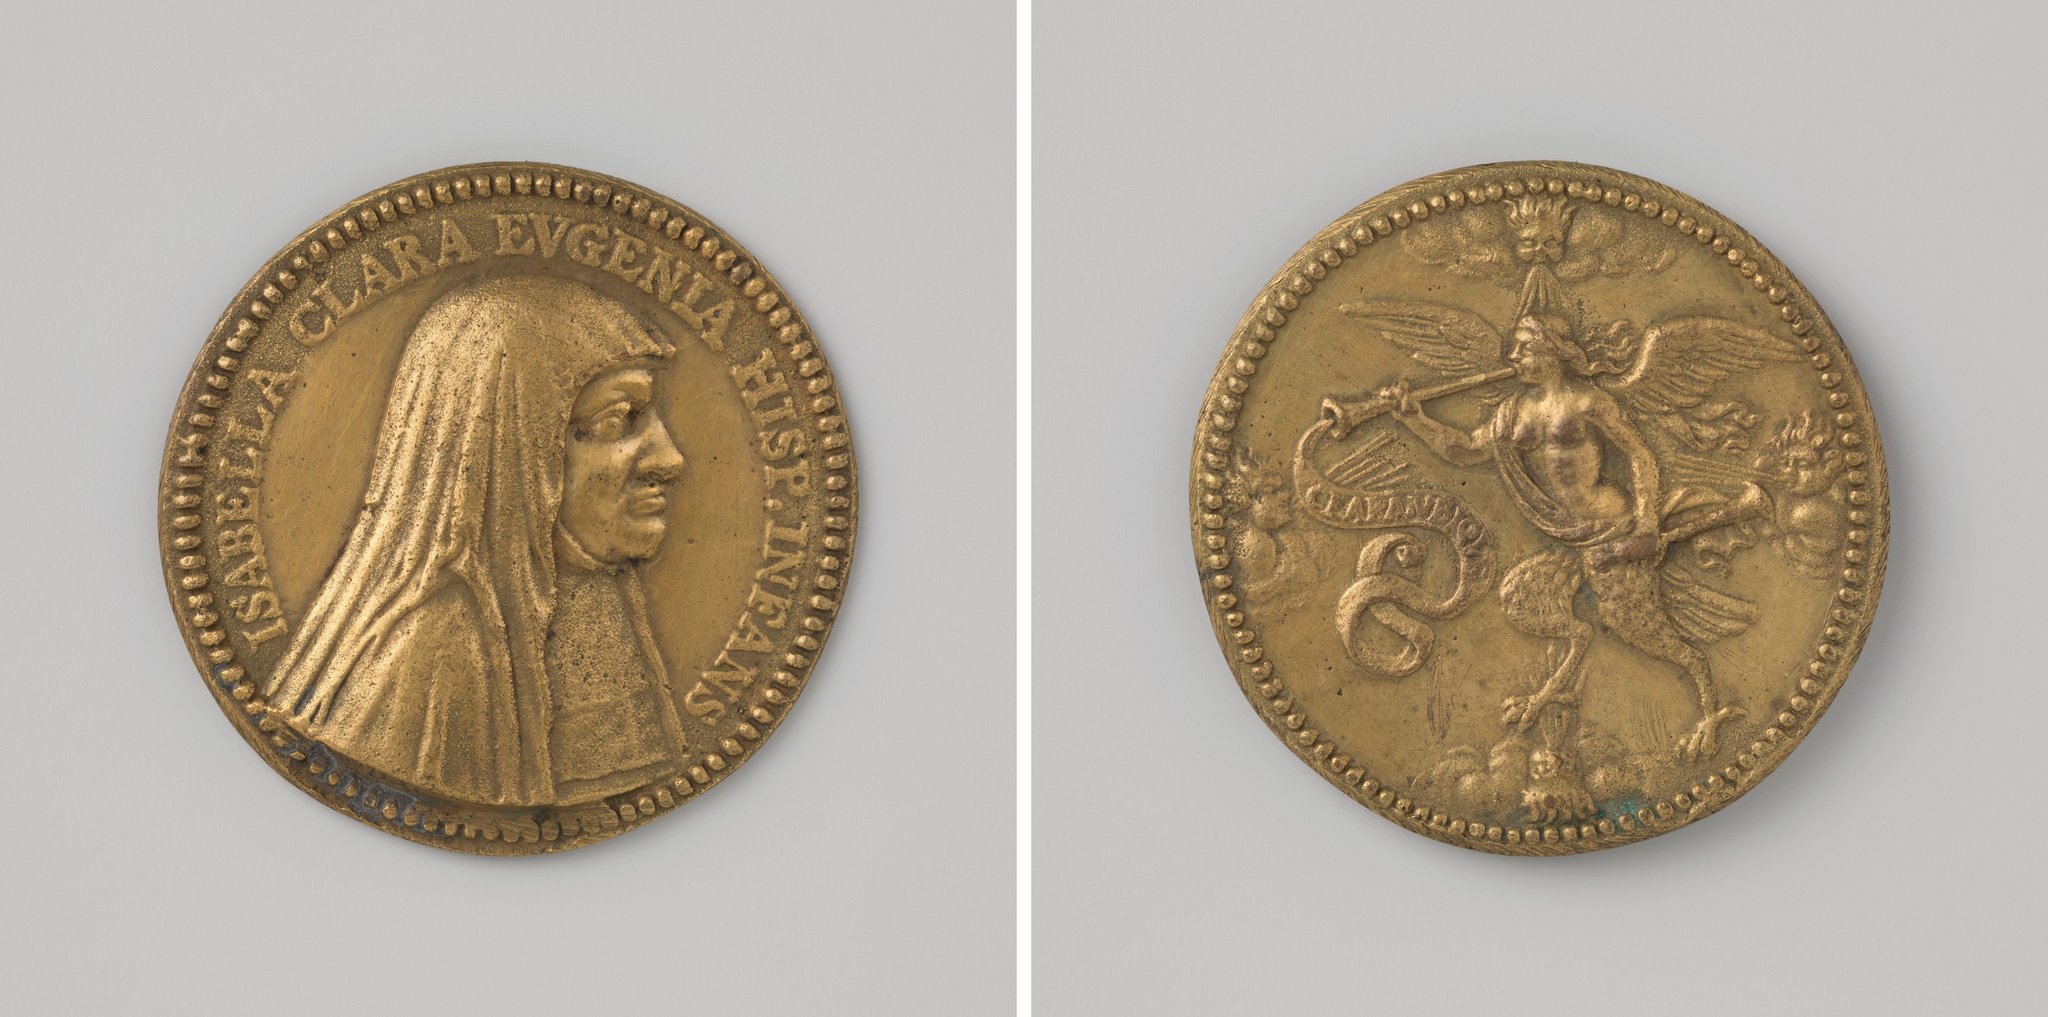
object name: history medal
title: Infante Isabella Clara Eugenia, dochter van Philips II van Spanje, gaat over tot de geestelijke stand 1622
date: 1622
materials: brass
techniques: casting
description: Messing penning, op de voorzijde het borstbeeld van de Infante naar rechts met omschrift, op de keerzijde, te midden van de vier winden, een gevleugelde Faam, half arend, die op een klaroen de spreuk CLARA VBIQVE blaast (zichtbaar op een wimpel).